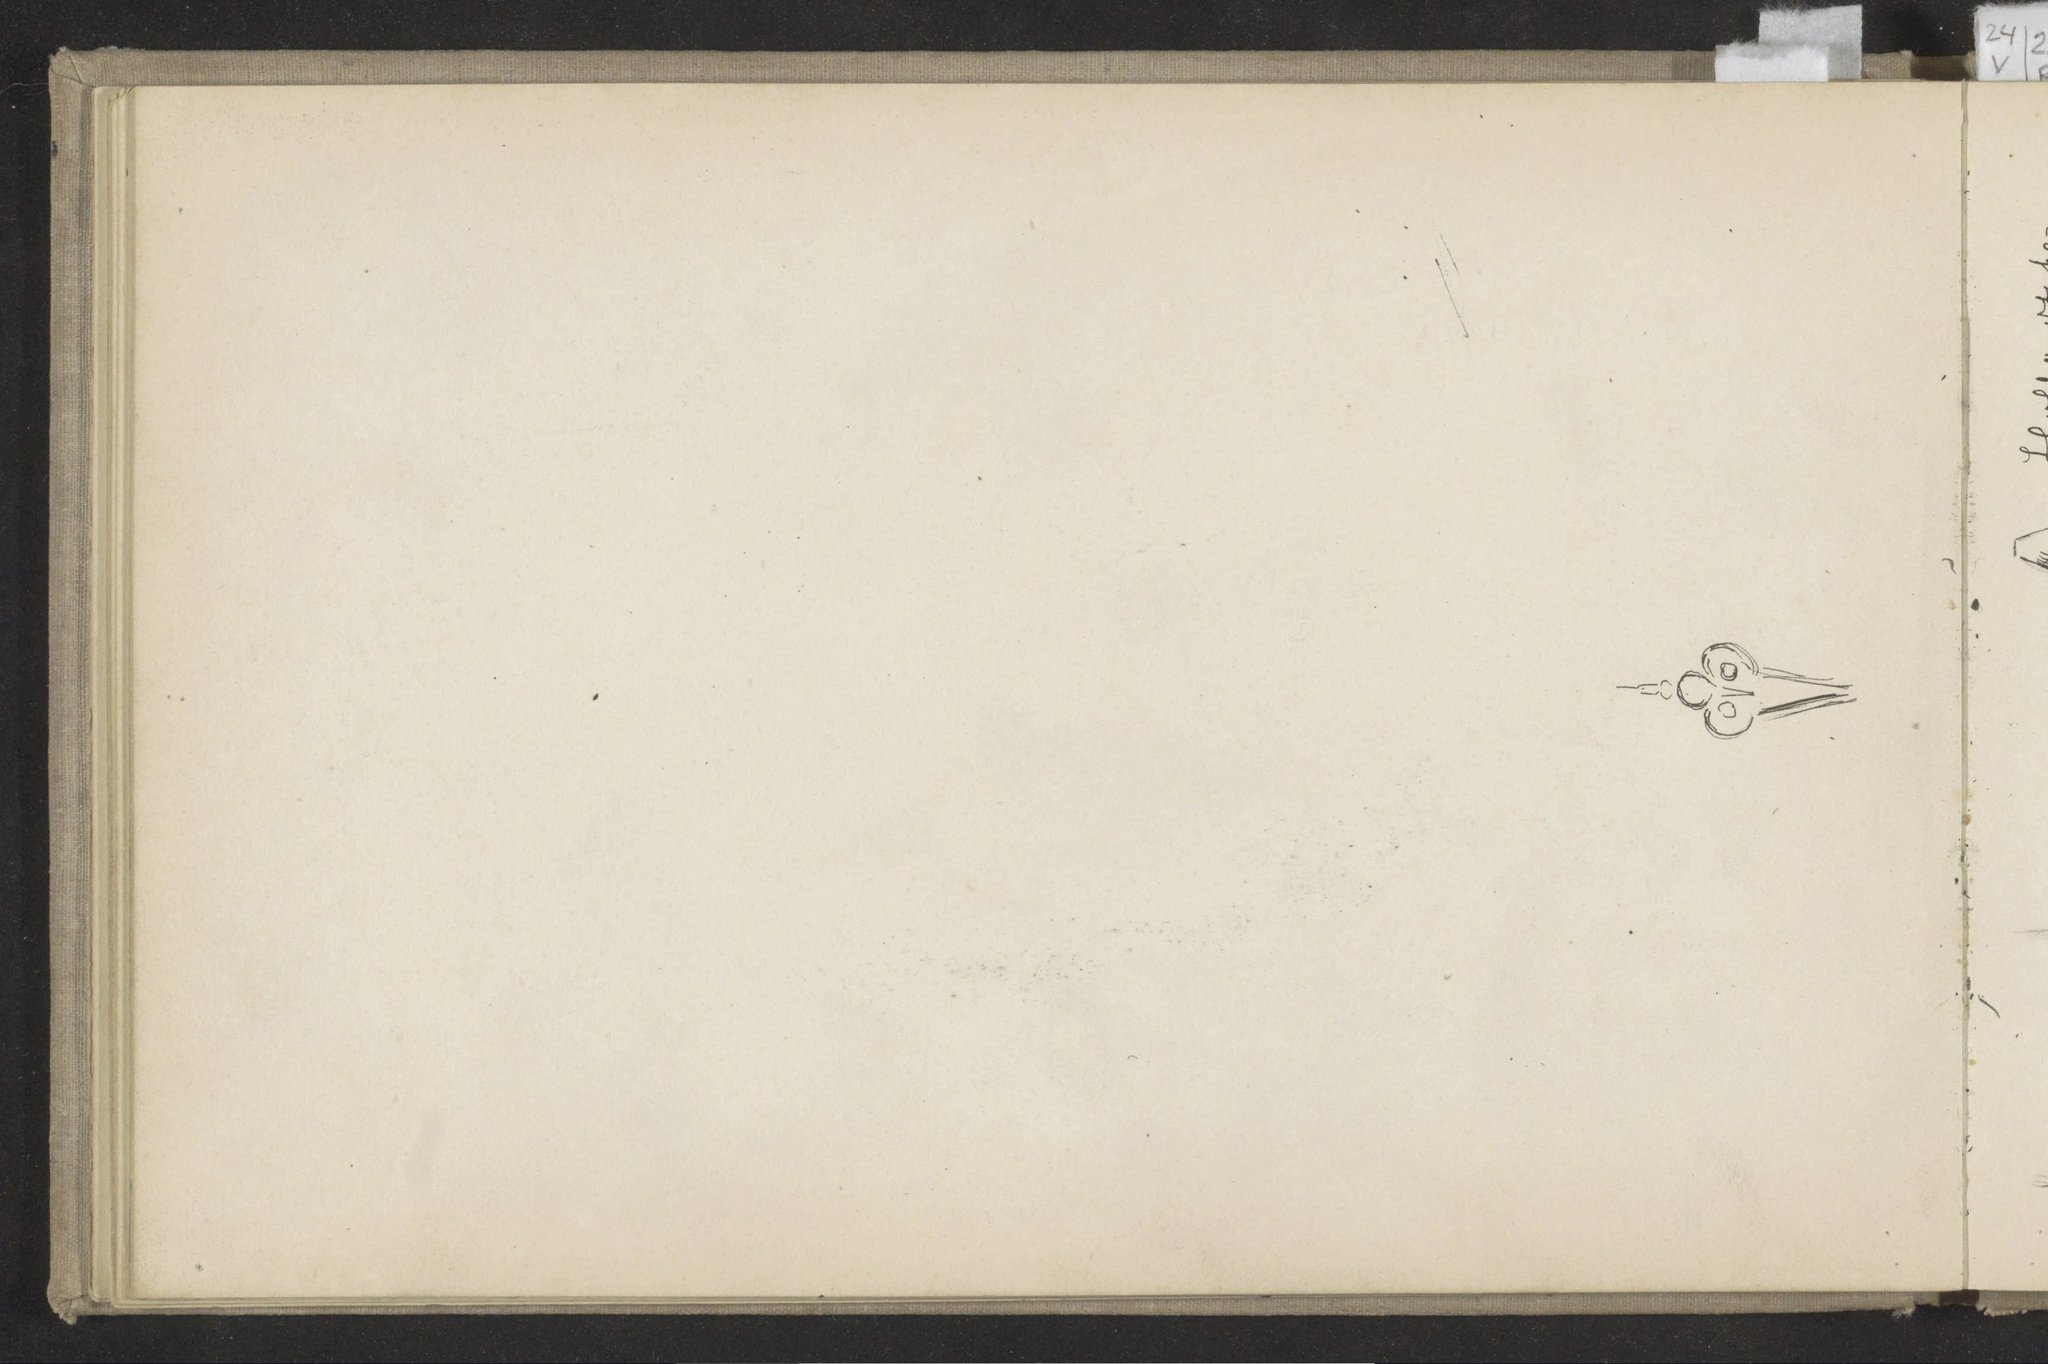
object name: sketchbook leaf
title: Ornament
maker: johanna van de kamer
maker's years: 1873-1922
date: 1890-1922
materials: ink, paper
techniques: pen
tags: ornaments ~ art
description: Blad 20 verso uit een schetsboek met 49 bladen.